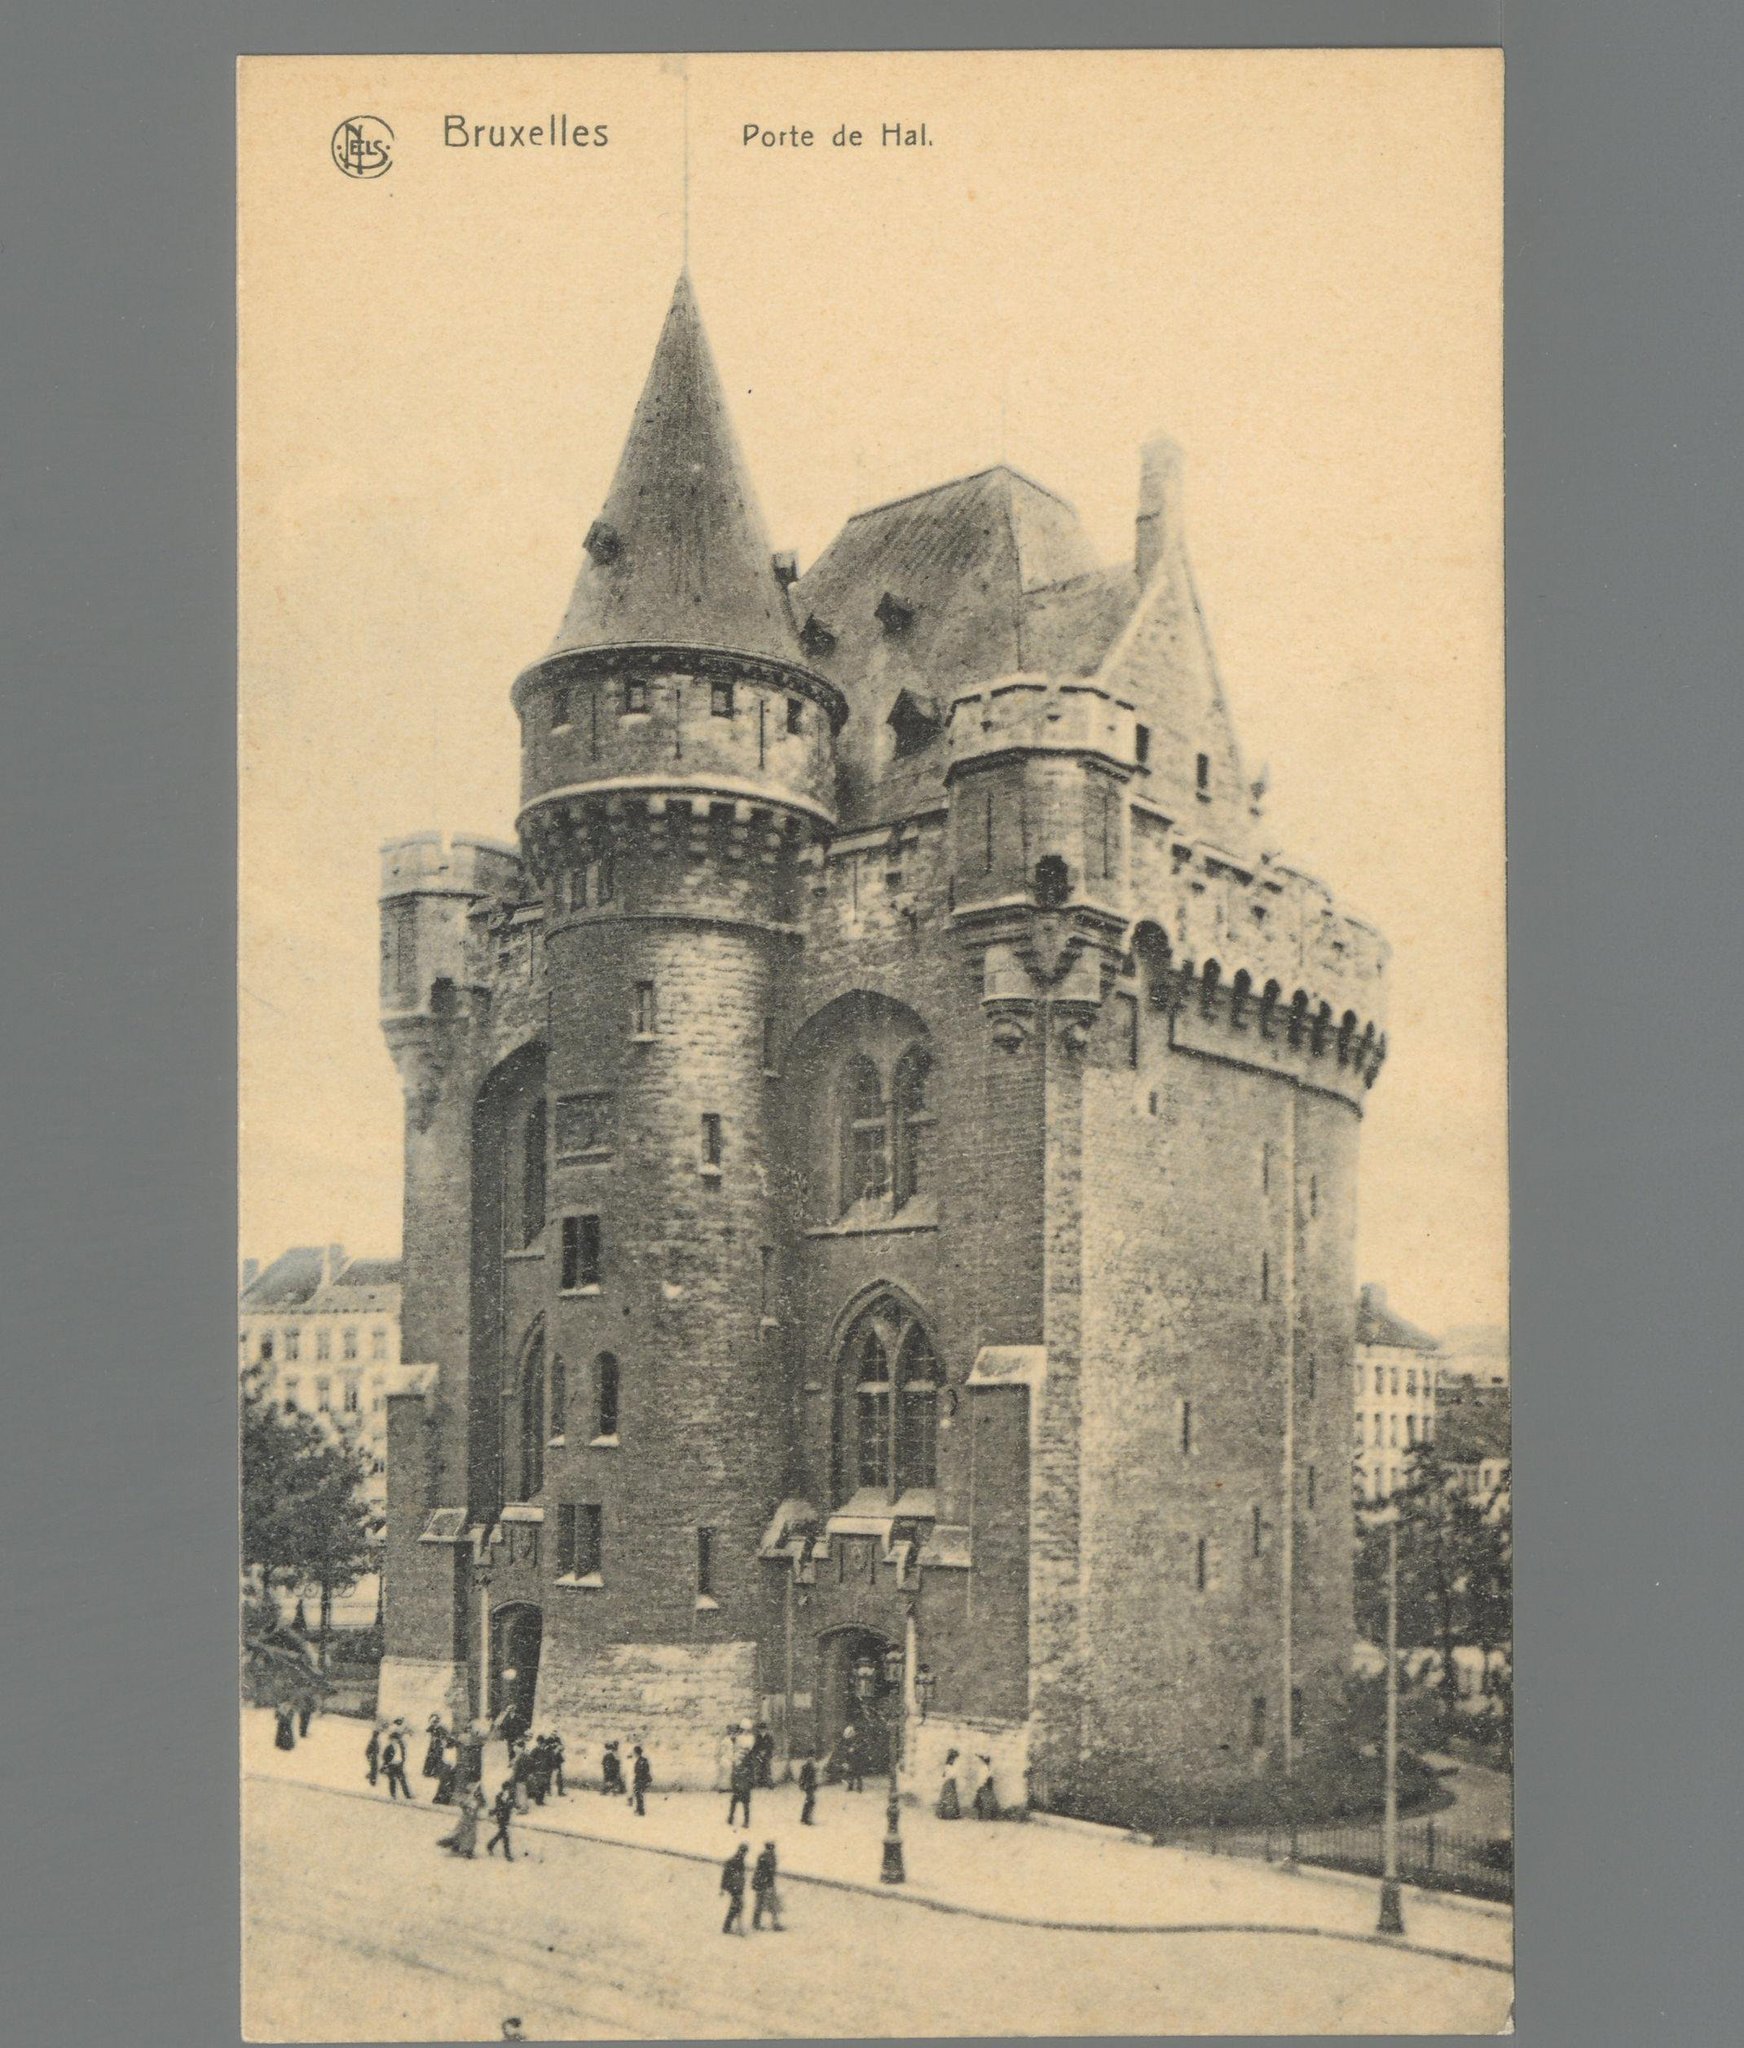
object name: ansichtkaart, prentbriefkaart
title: Serie Bruxelles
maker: Anonymous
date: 1907-1913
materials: cardboard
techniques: photograph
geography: brussels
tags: city-gate, city-view, and landscape with man-made constructions (+ city(-scape) with figures, staffage)